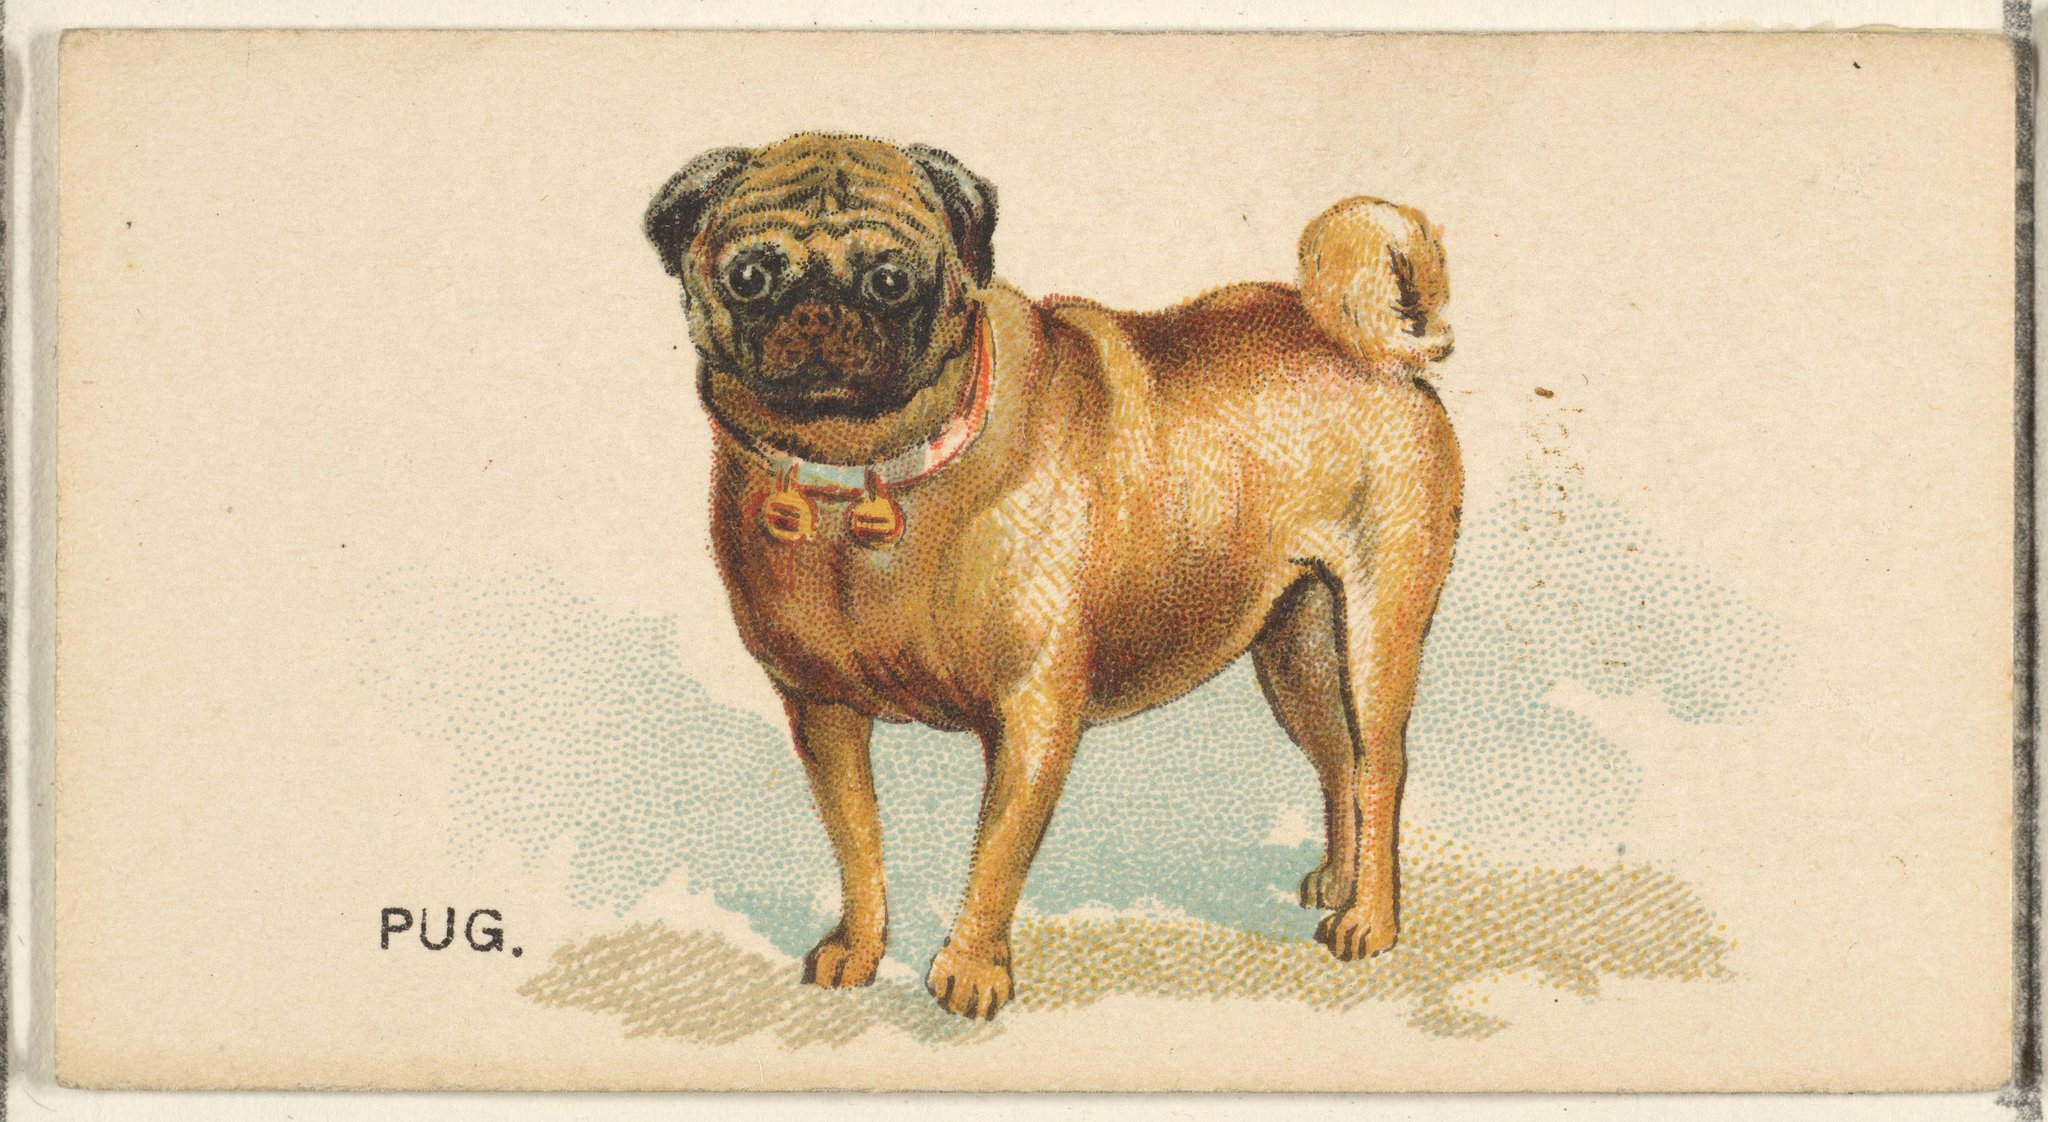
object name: print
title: Pug, from the Dogs of the World series for Old Judge Cigarettes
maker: goodwin & company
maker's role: publisher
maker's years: 1850-1950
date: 1890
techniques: color lithograph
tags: dogs